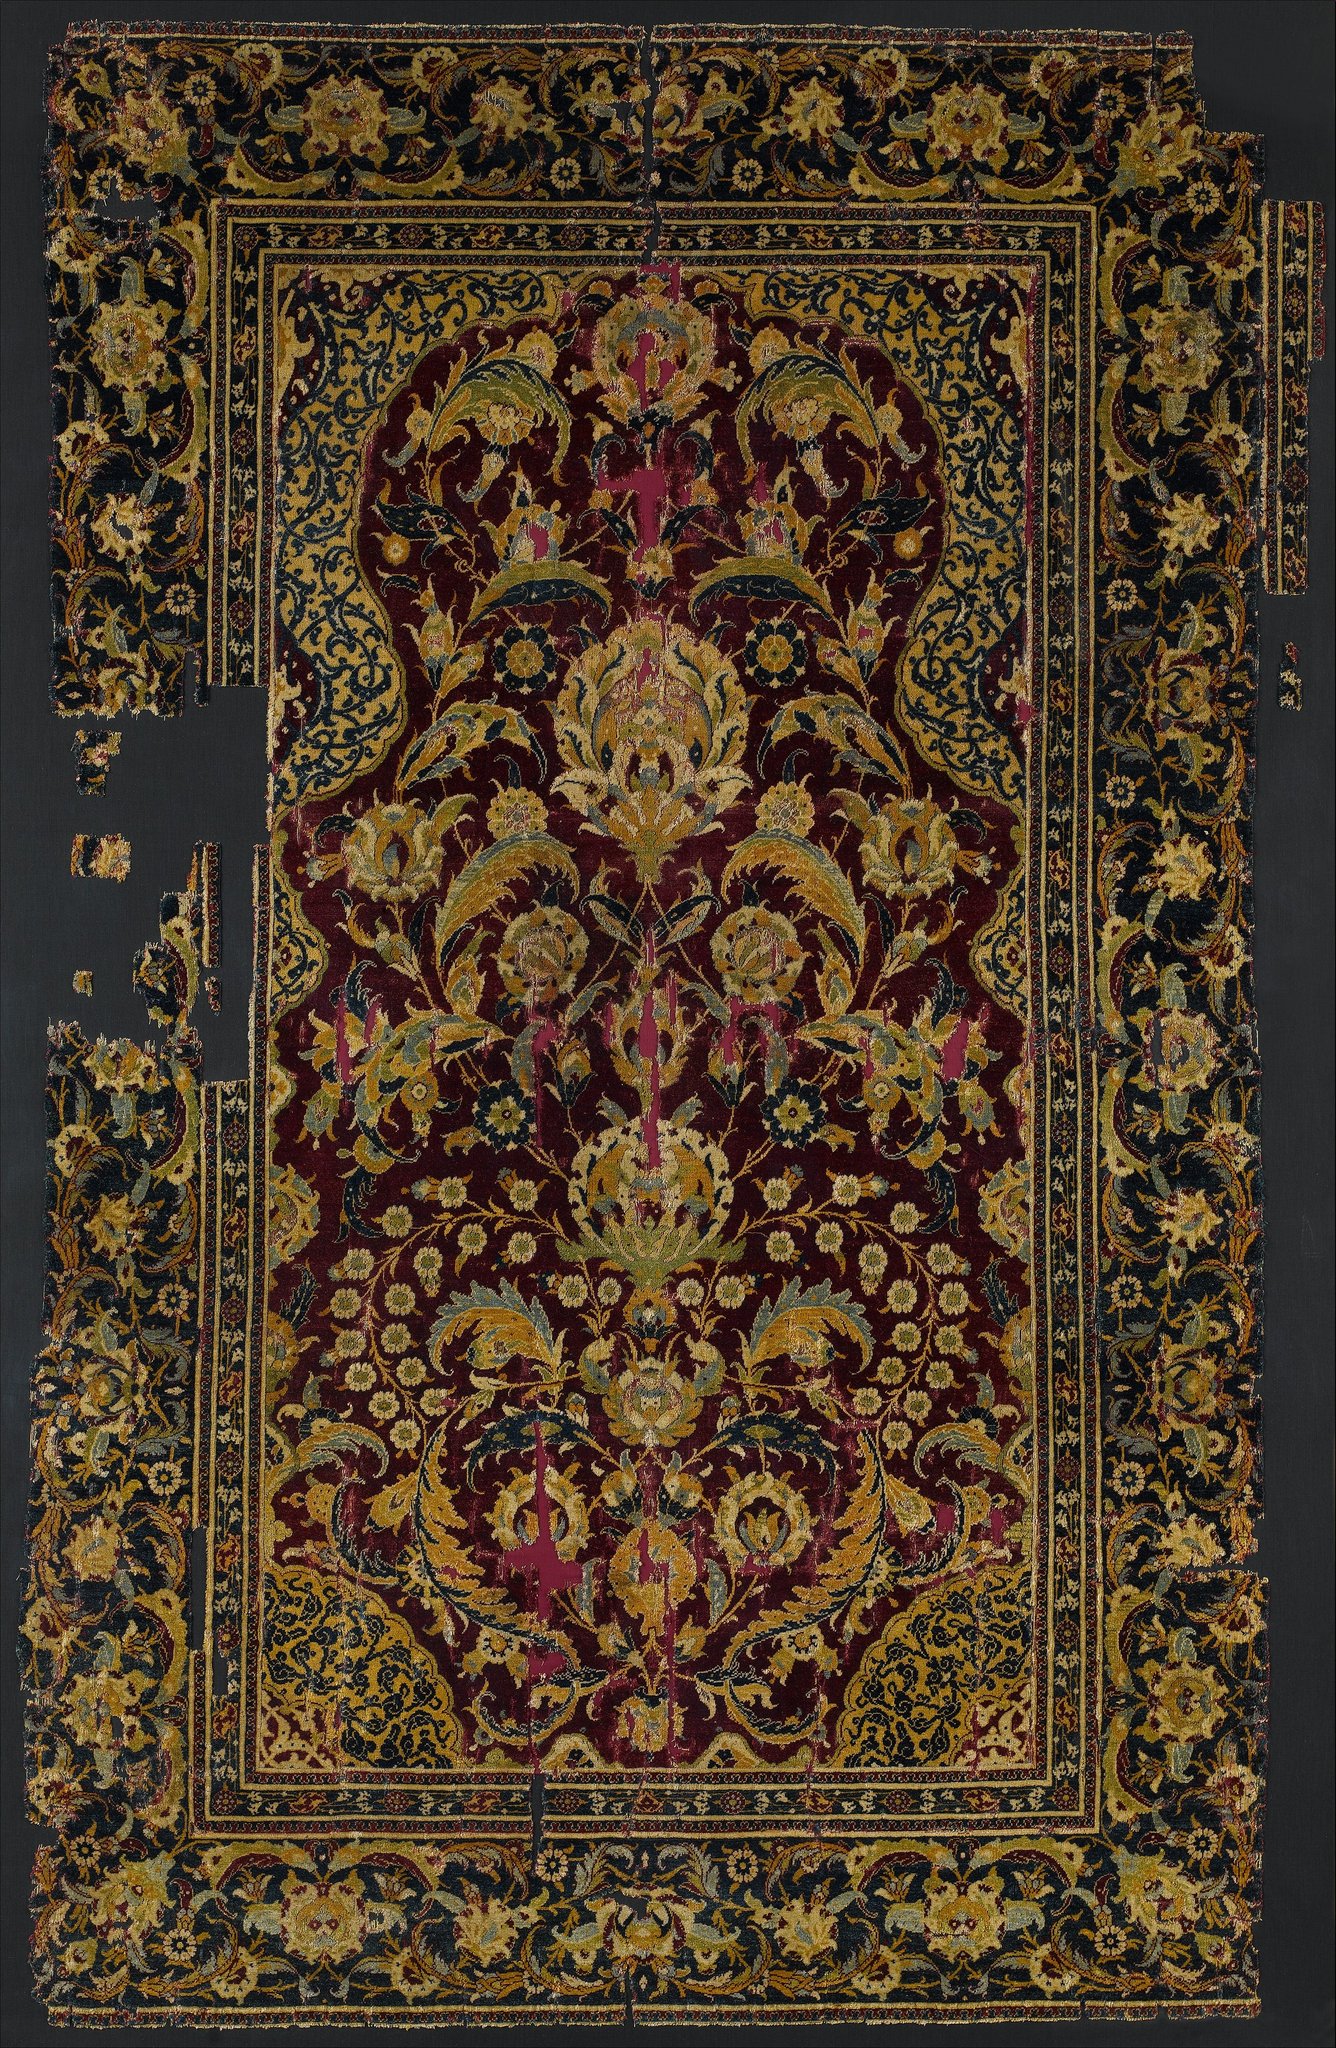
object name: carpet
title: Prayer Rug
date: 1567-1600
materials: silk, thread, wool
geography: egypt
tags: flowers